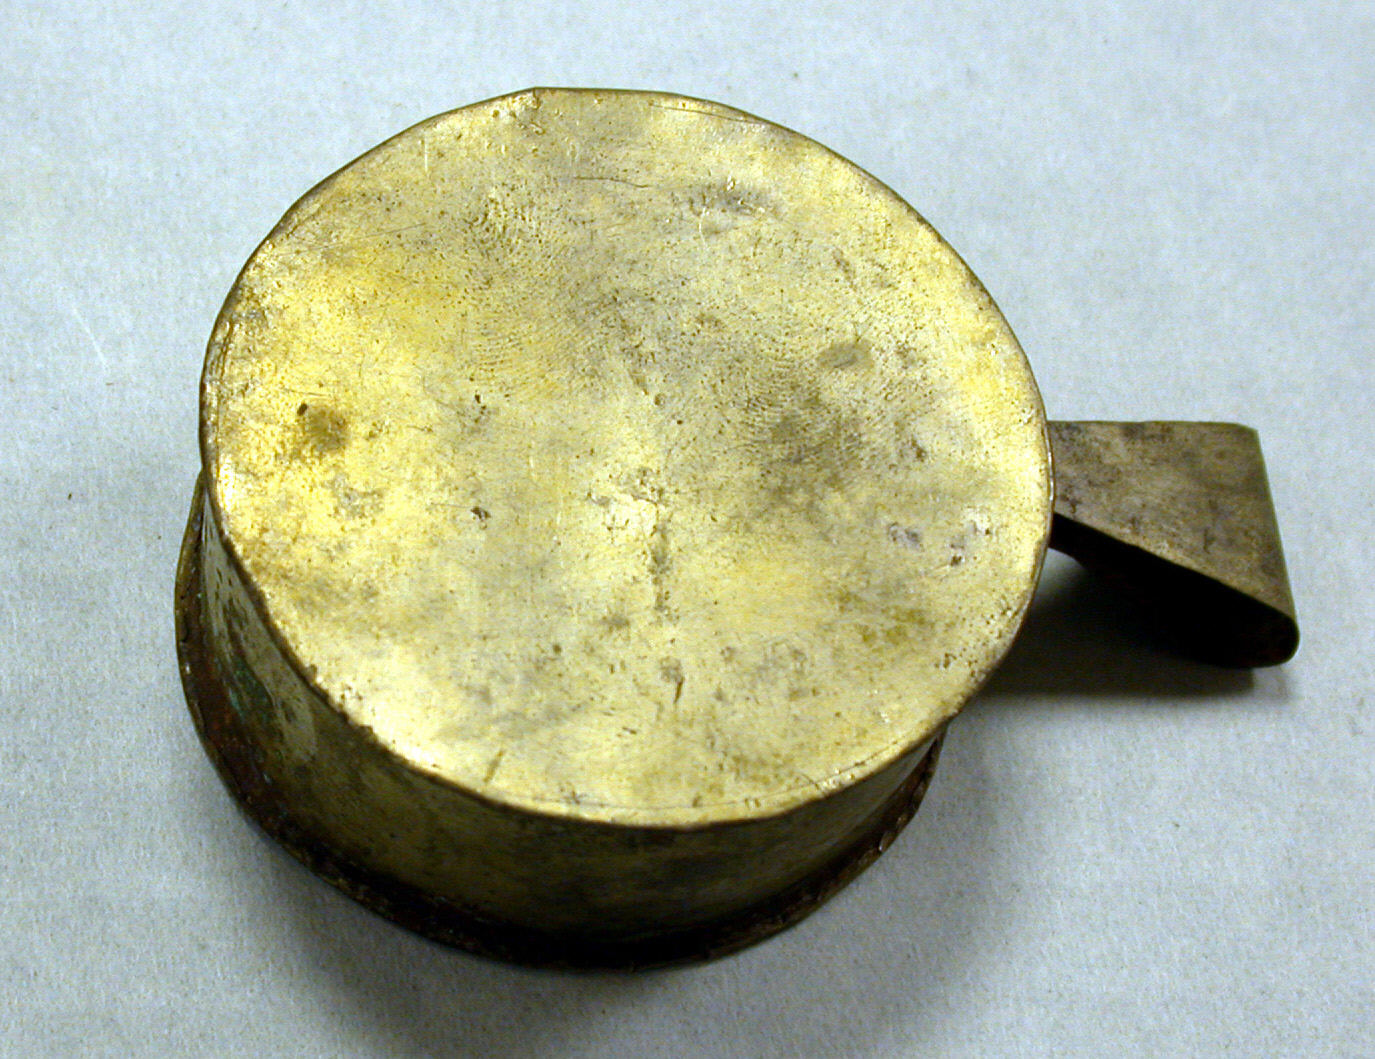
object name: drum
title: Hammered Silver Miniature Drum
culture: chancay or chimú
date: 1001-1466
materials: gilt, silver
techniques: hammering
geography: peru